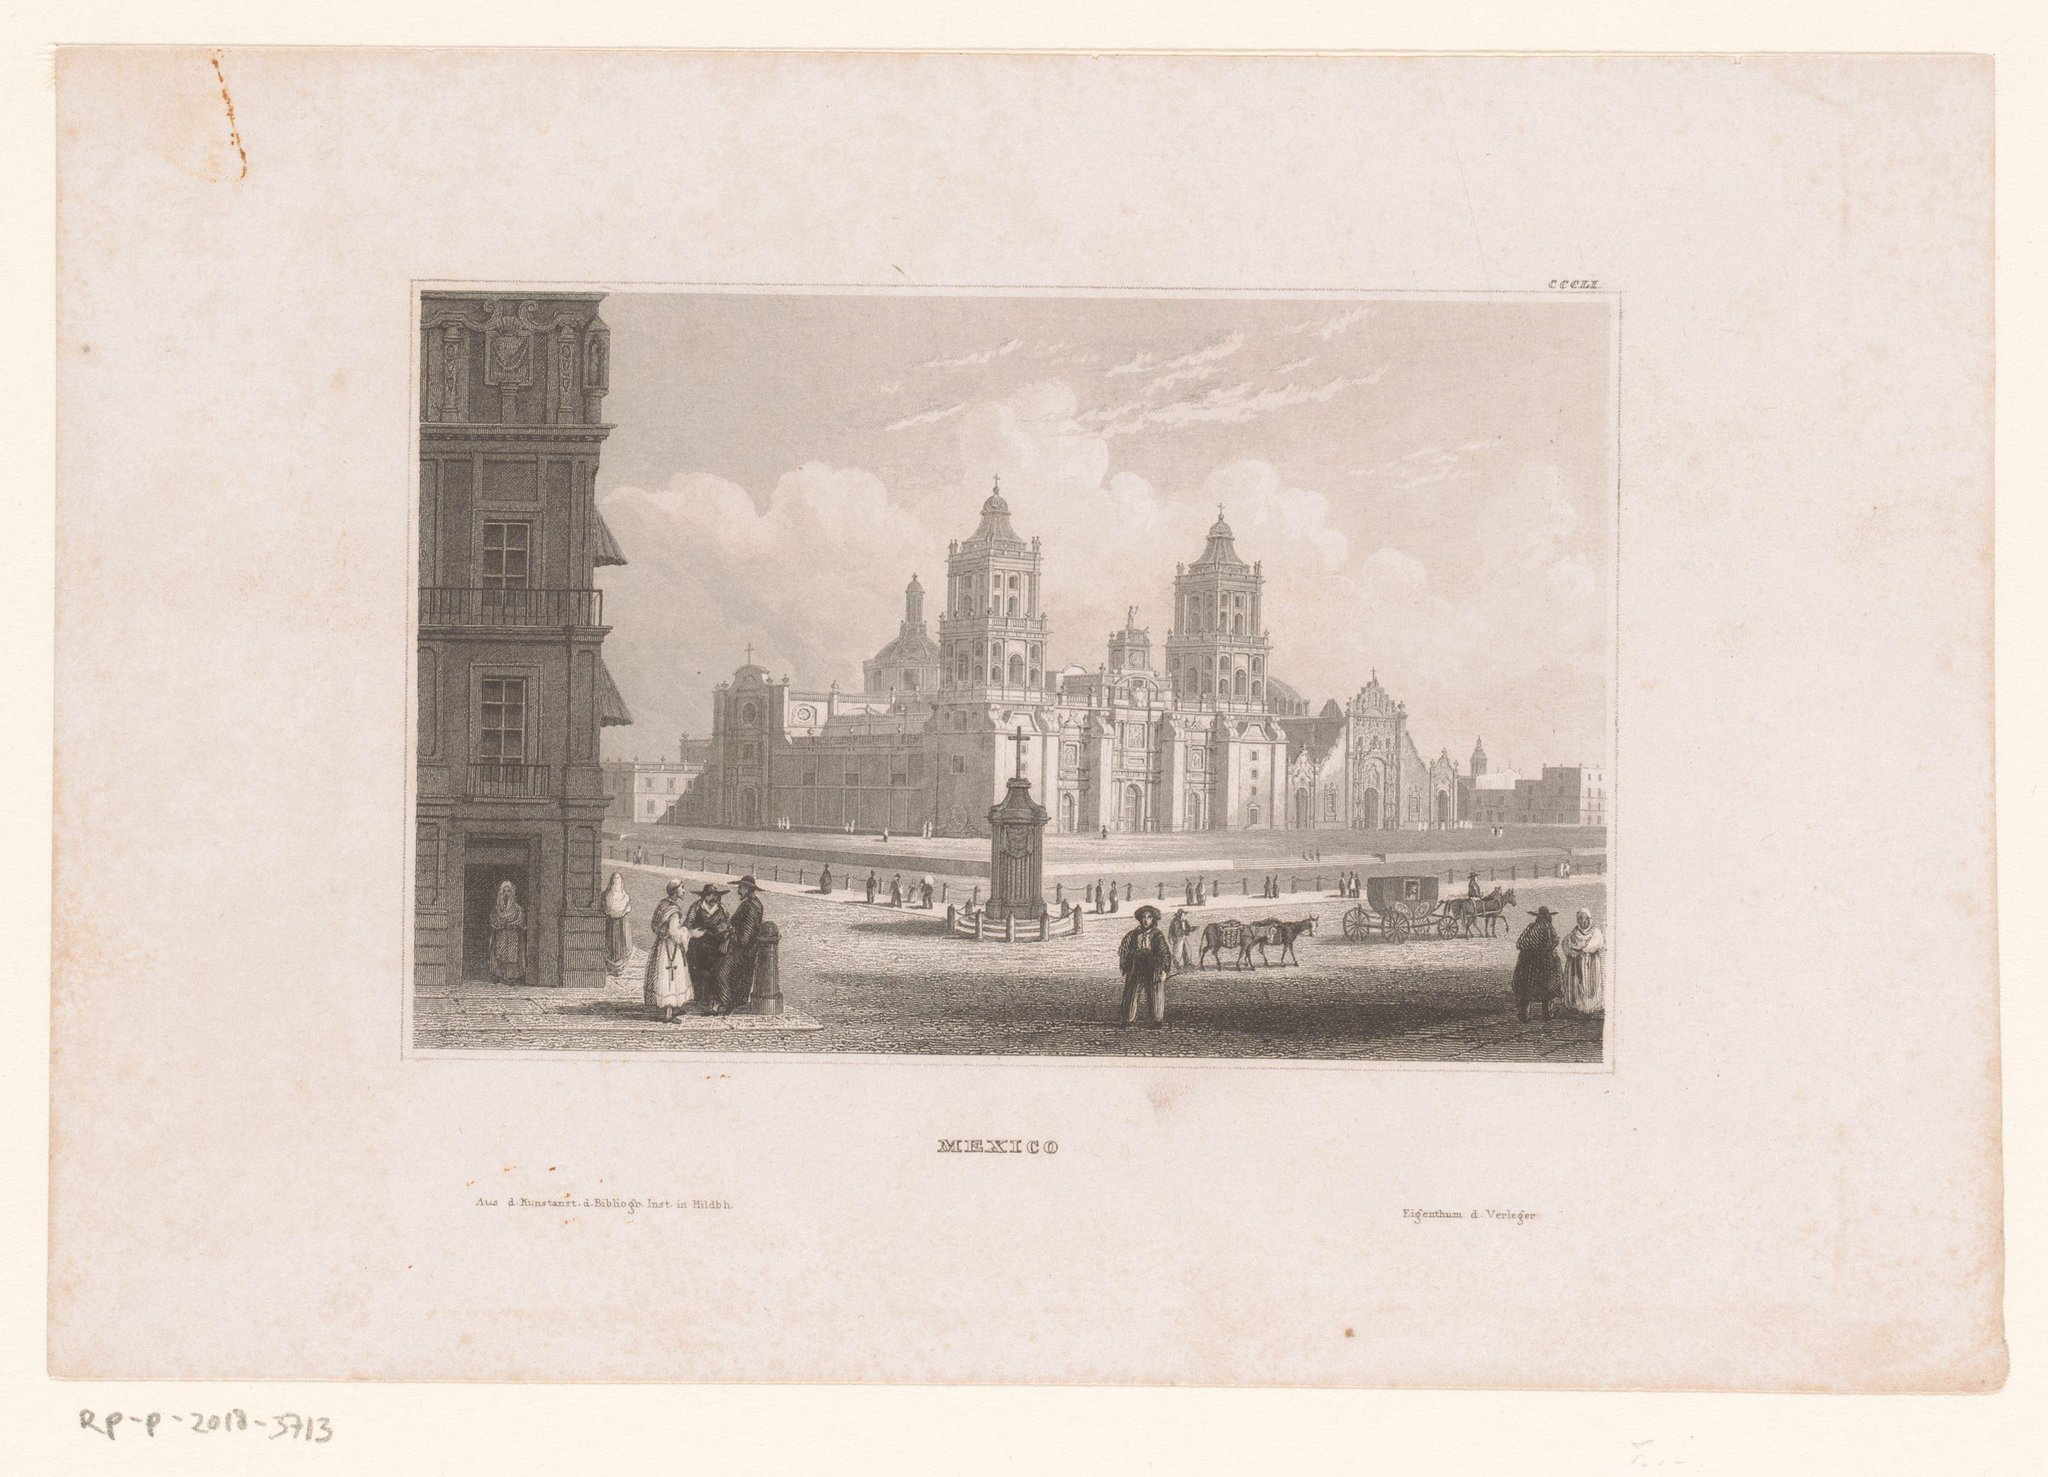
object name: print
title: Mexico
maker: Anonymous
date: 1835-1863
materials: paper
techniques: engraving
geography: hildburghausen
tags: city-view, and landscape with man-made constructions, village square, place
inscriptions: collector's mark: Lugt 2228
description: Prent verschenen in: Meyer, Joseph. Meyer's Universum. Hildburghausen: Bibliographisches Institut, 1835-1863.